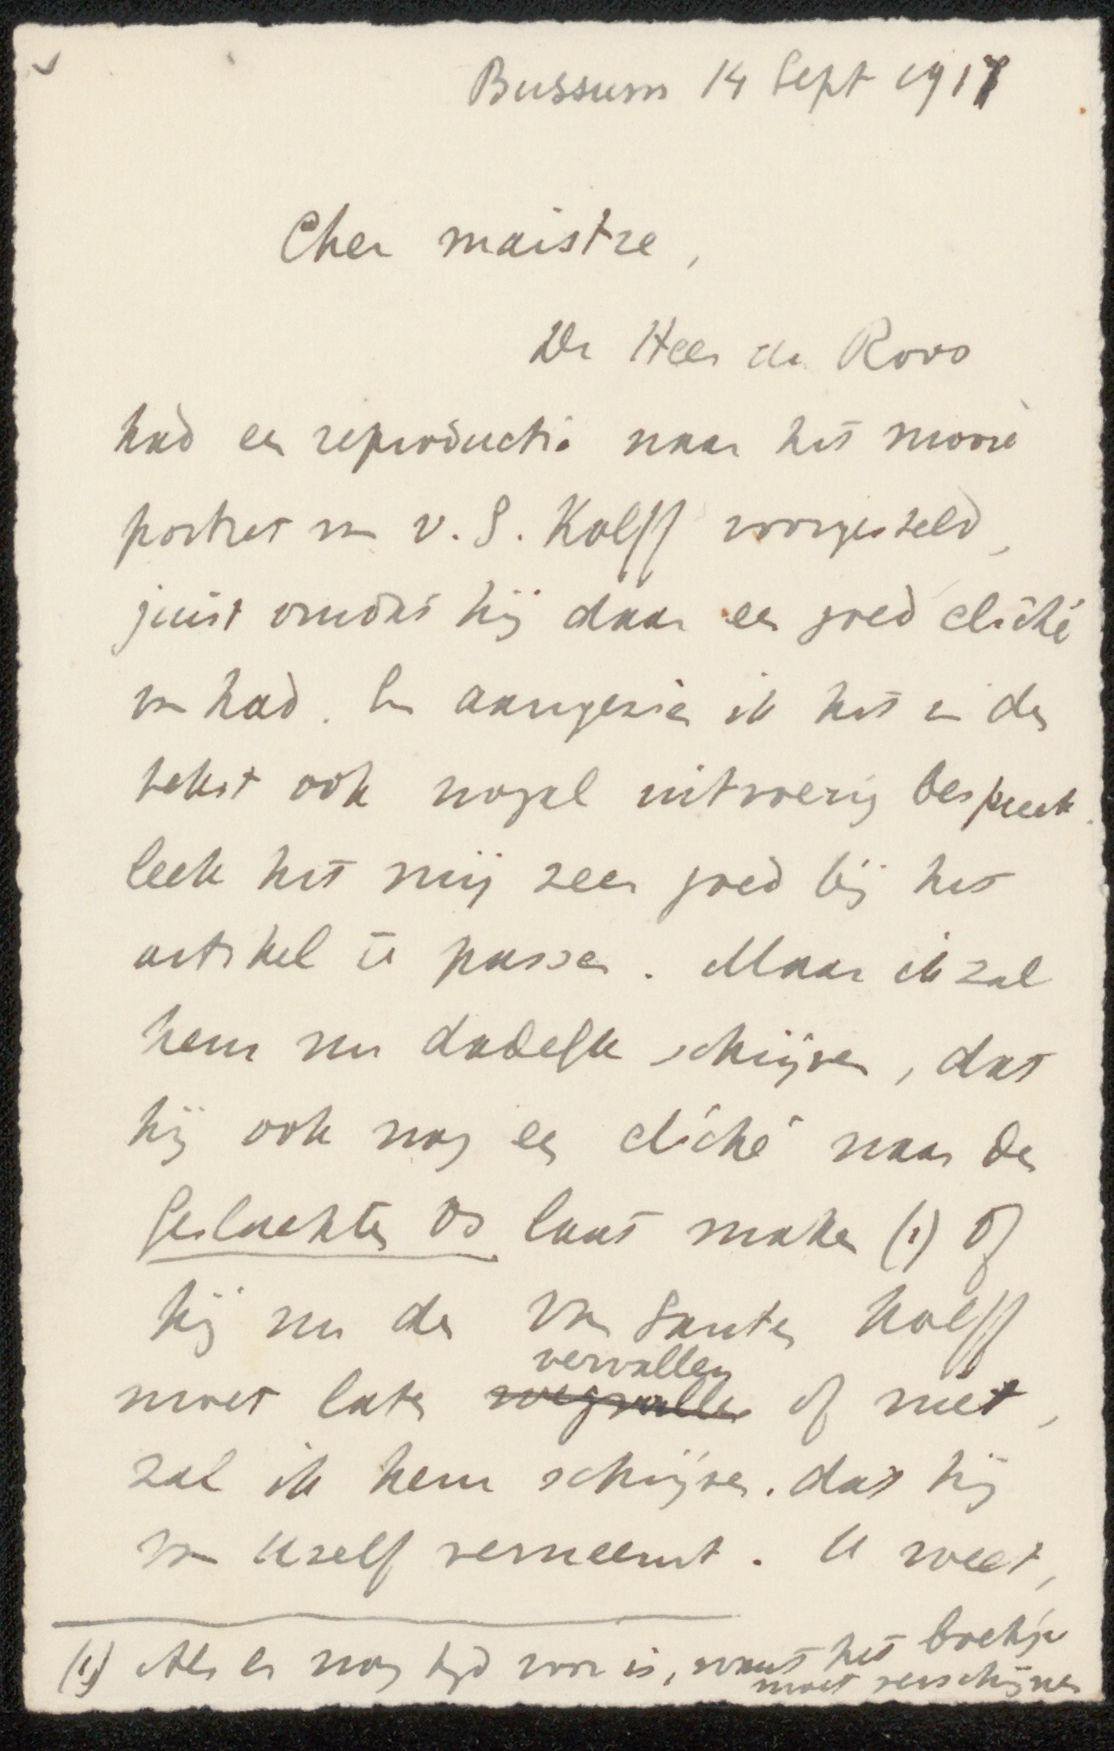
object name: letter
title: Brief aan August Allebé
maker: jan veth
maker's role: designer, draughtsman, painter, print maker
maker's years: 1864-1925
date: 1917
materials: ink, paper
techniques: pen, writing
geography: bussum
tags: august allebé, haarlem, print maker, draughtsman, sjoerd hendrik de roos, rotterdam, historical persons (portraits and scenes from the life), printed matter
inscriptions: collector's mark: ‘RPK’